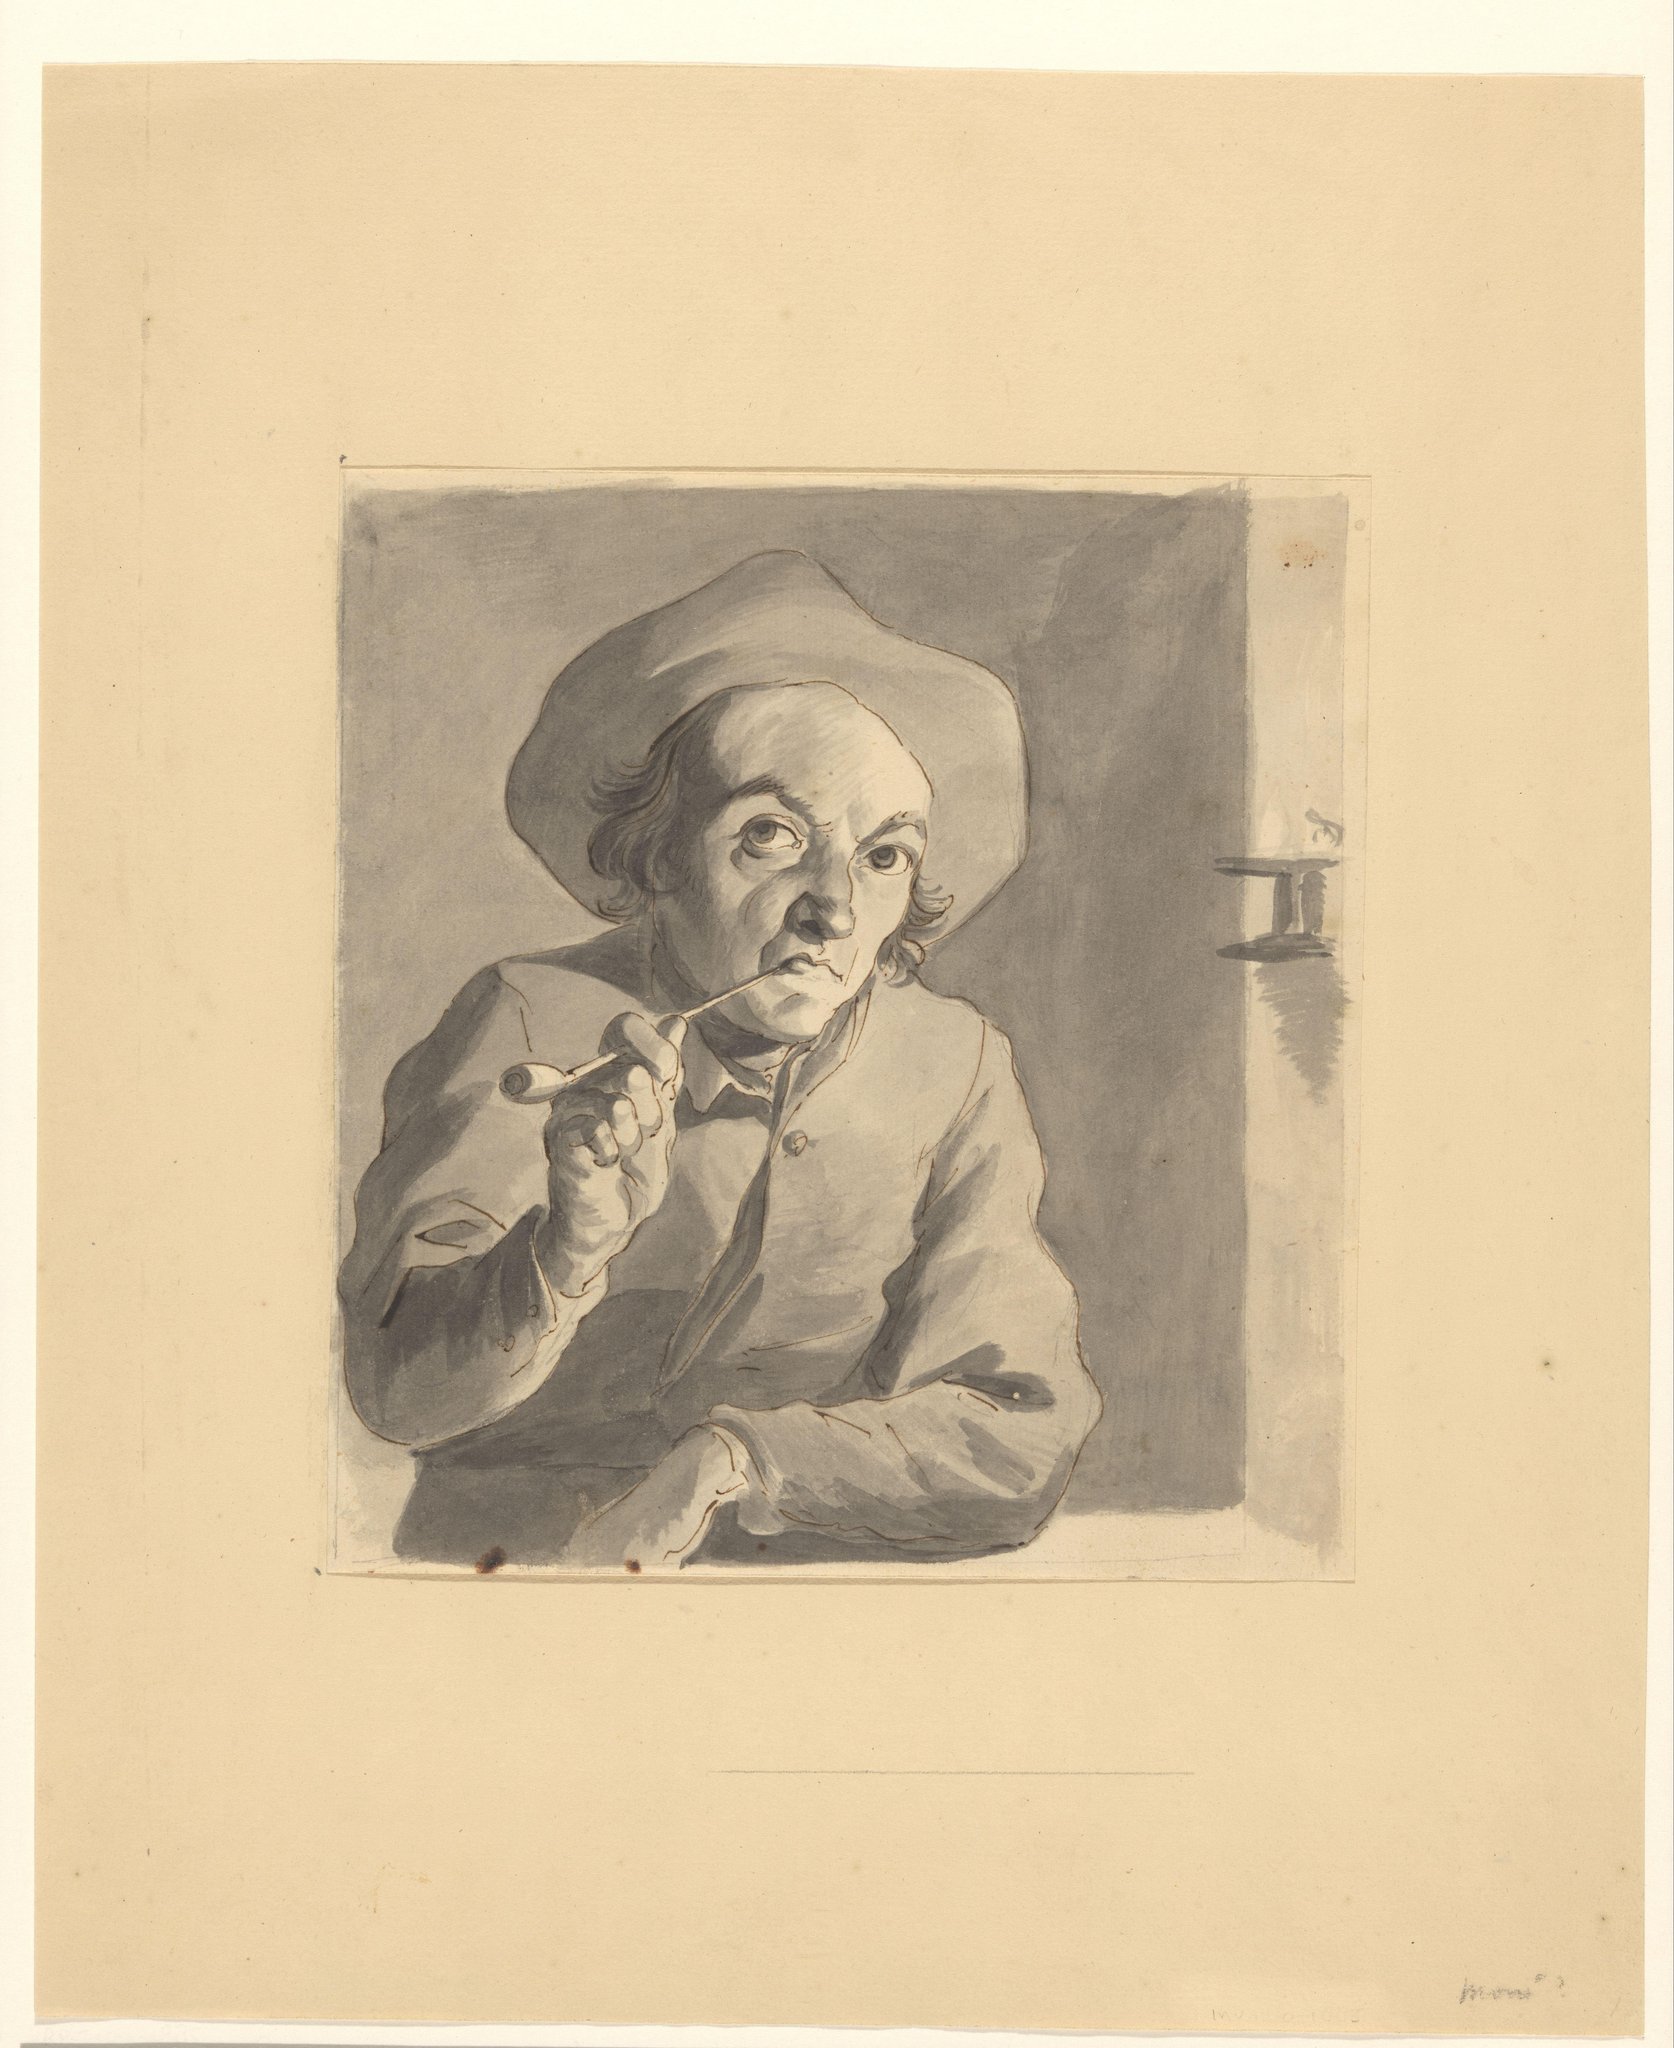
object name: drawing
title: Man met pijp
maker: Anonymous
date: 1700-1800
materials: ink, paper, pencil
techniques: brush, pen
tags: pipe ~ tobacco (+ taking (particular) foodstuffs: eating, drinking, smoking, chewing, etc.)